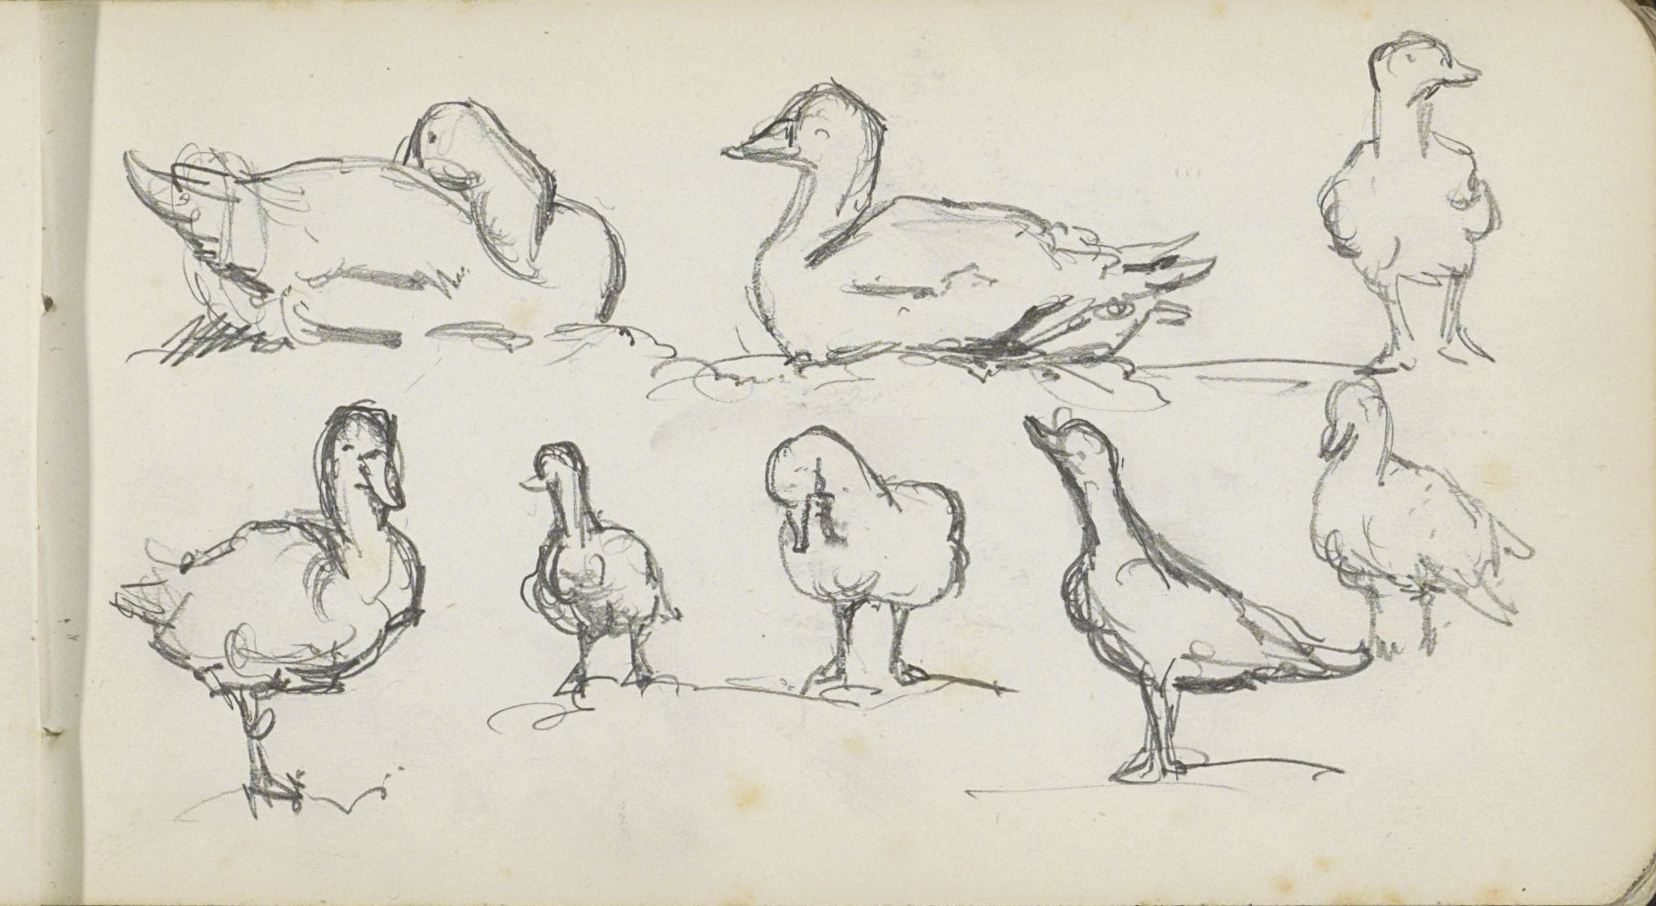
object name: sketchbook leaf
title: Studieblad met eenden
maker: geo poggenbeek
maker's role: draughtsman, painter, print maker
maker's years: 1853-1903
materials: paper, pencil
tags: water-birds: duck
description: Blad 15 recto uit een schetsboek met 69 bladen.